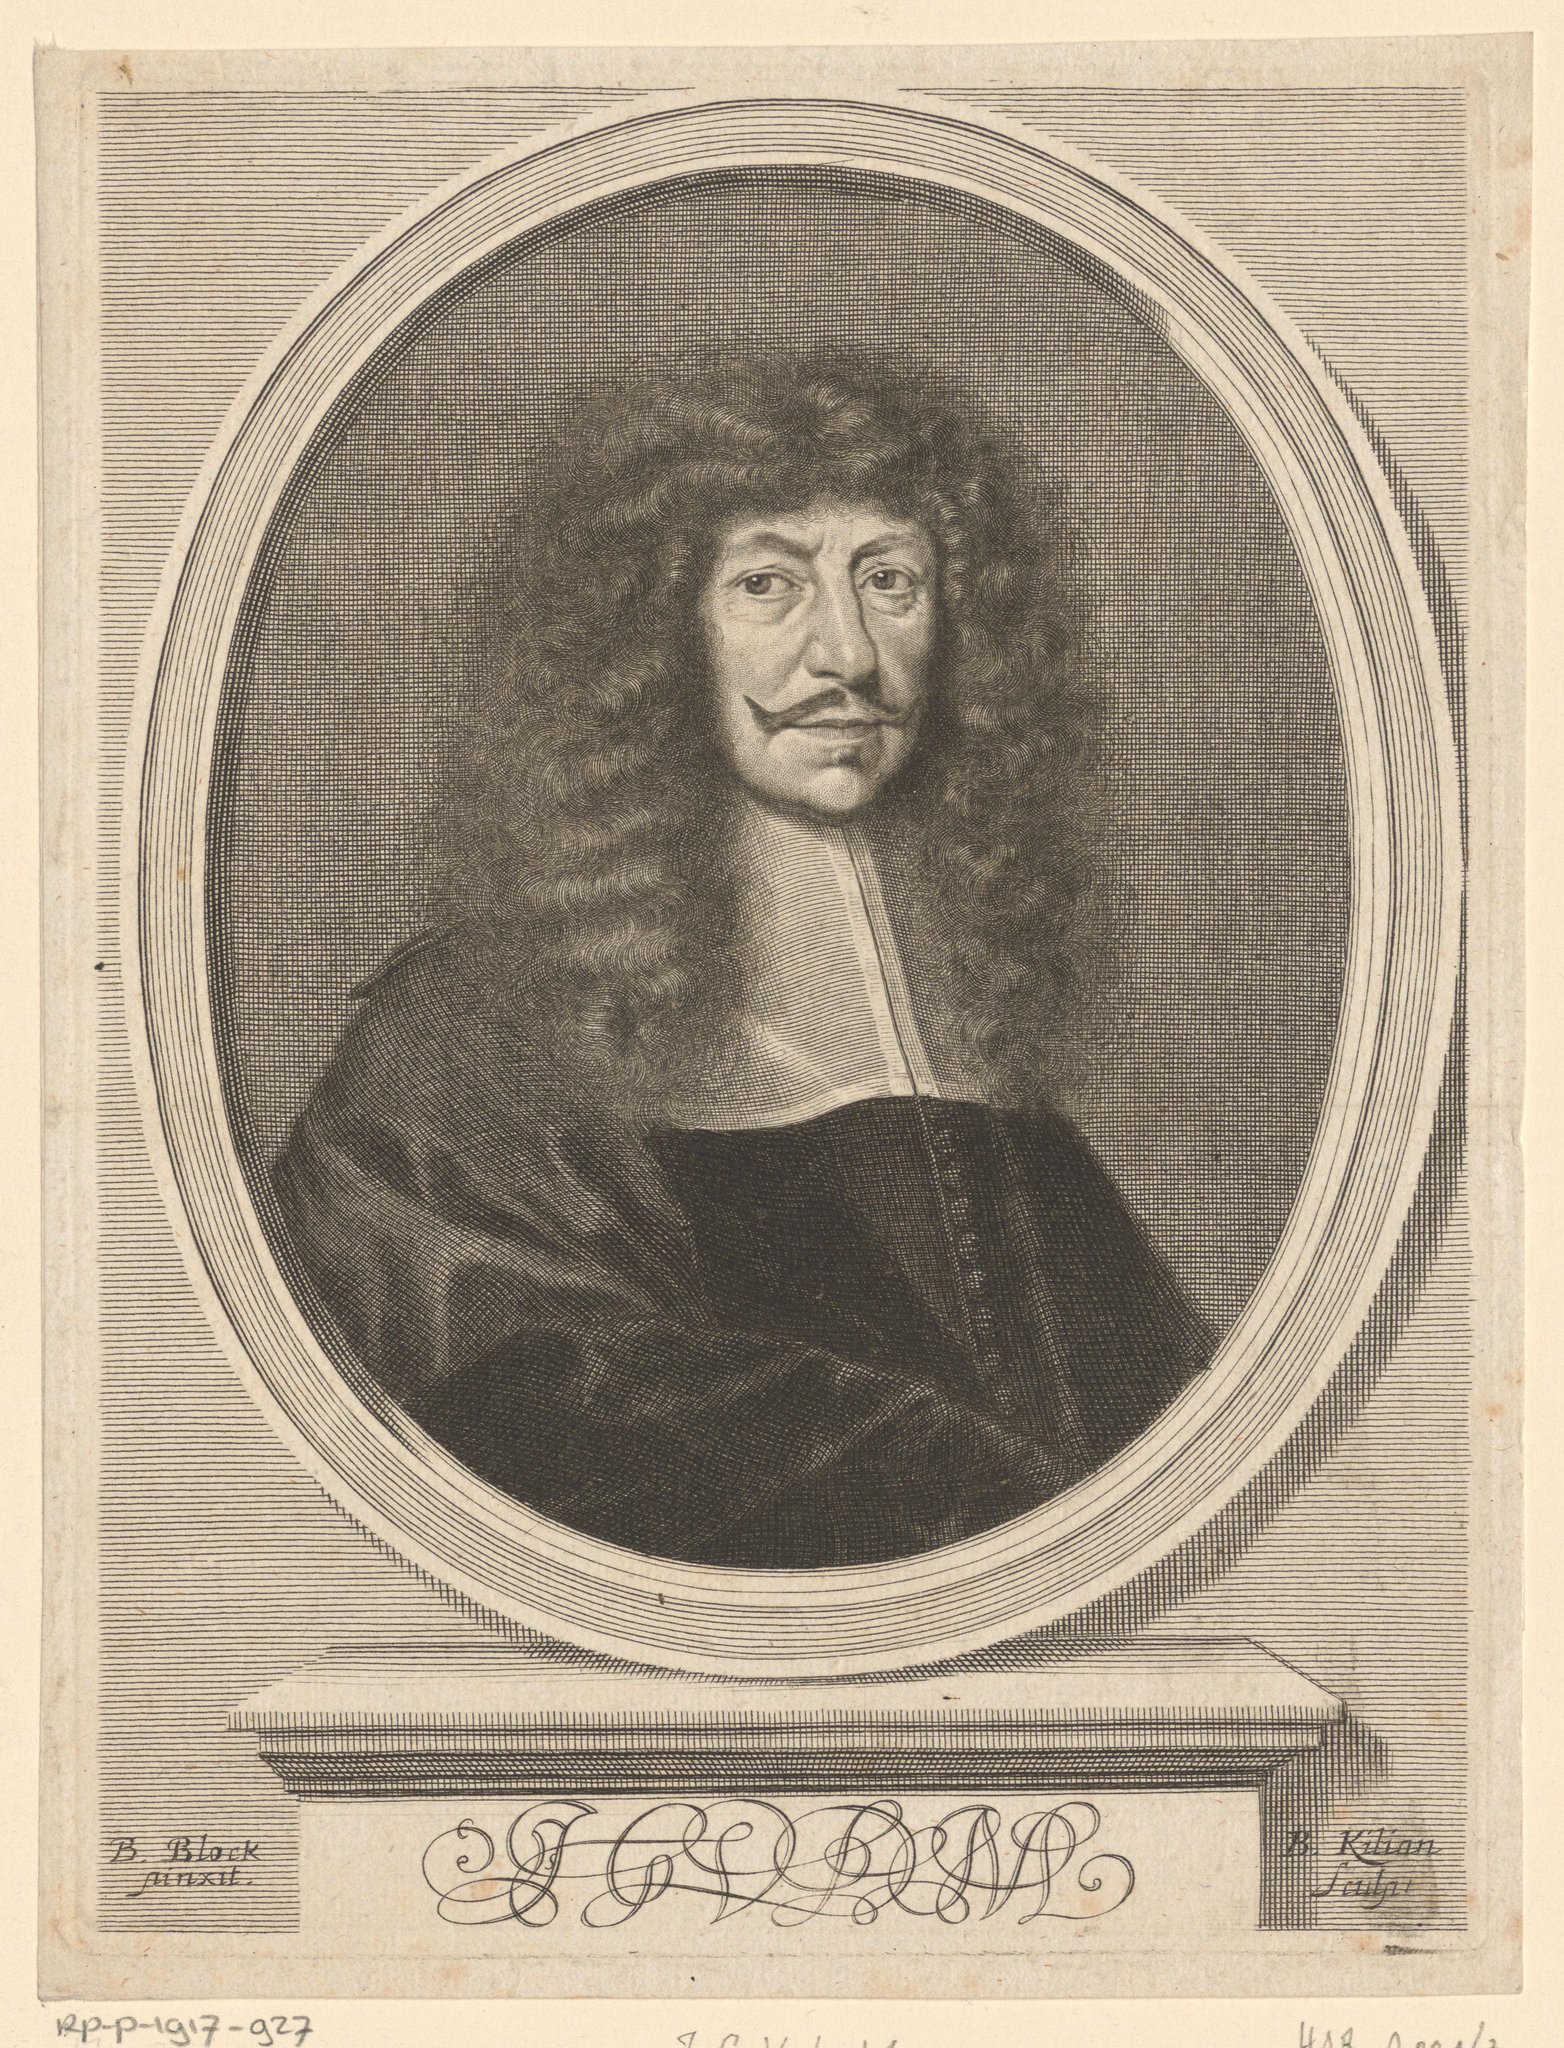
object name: print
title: Portret van Johann Georg Volckamer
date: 1640-1696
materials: paper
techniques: engraving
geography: augsburg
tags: johann georg volckamer (i), historical persons, portrait of a writer, physician, doctor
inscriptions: collector's mark: Lugt 2228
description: Met initialen JGVLM in het onderschrift.